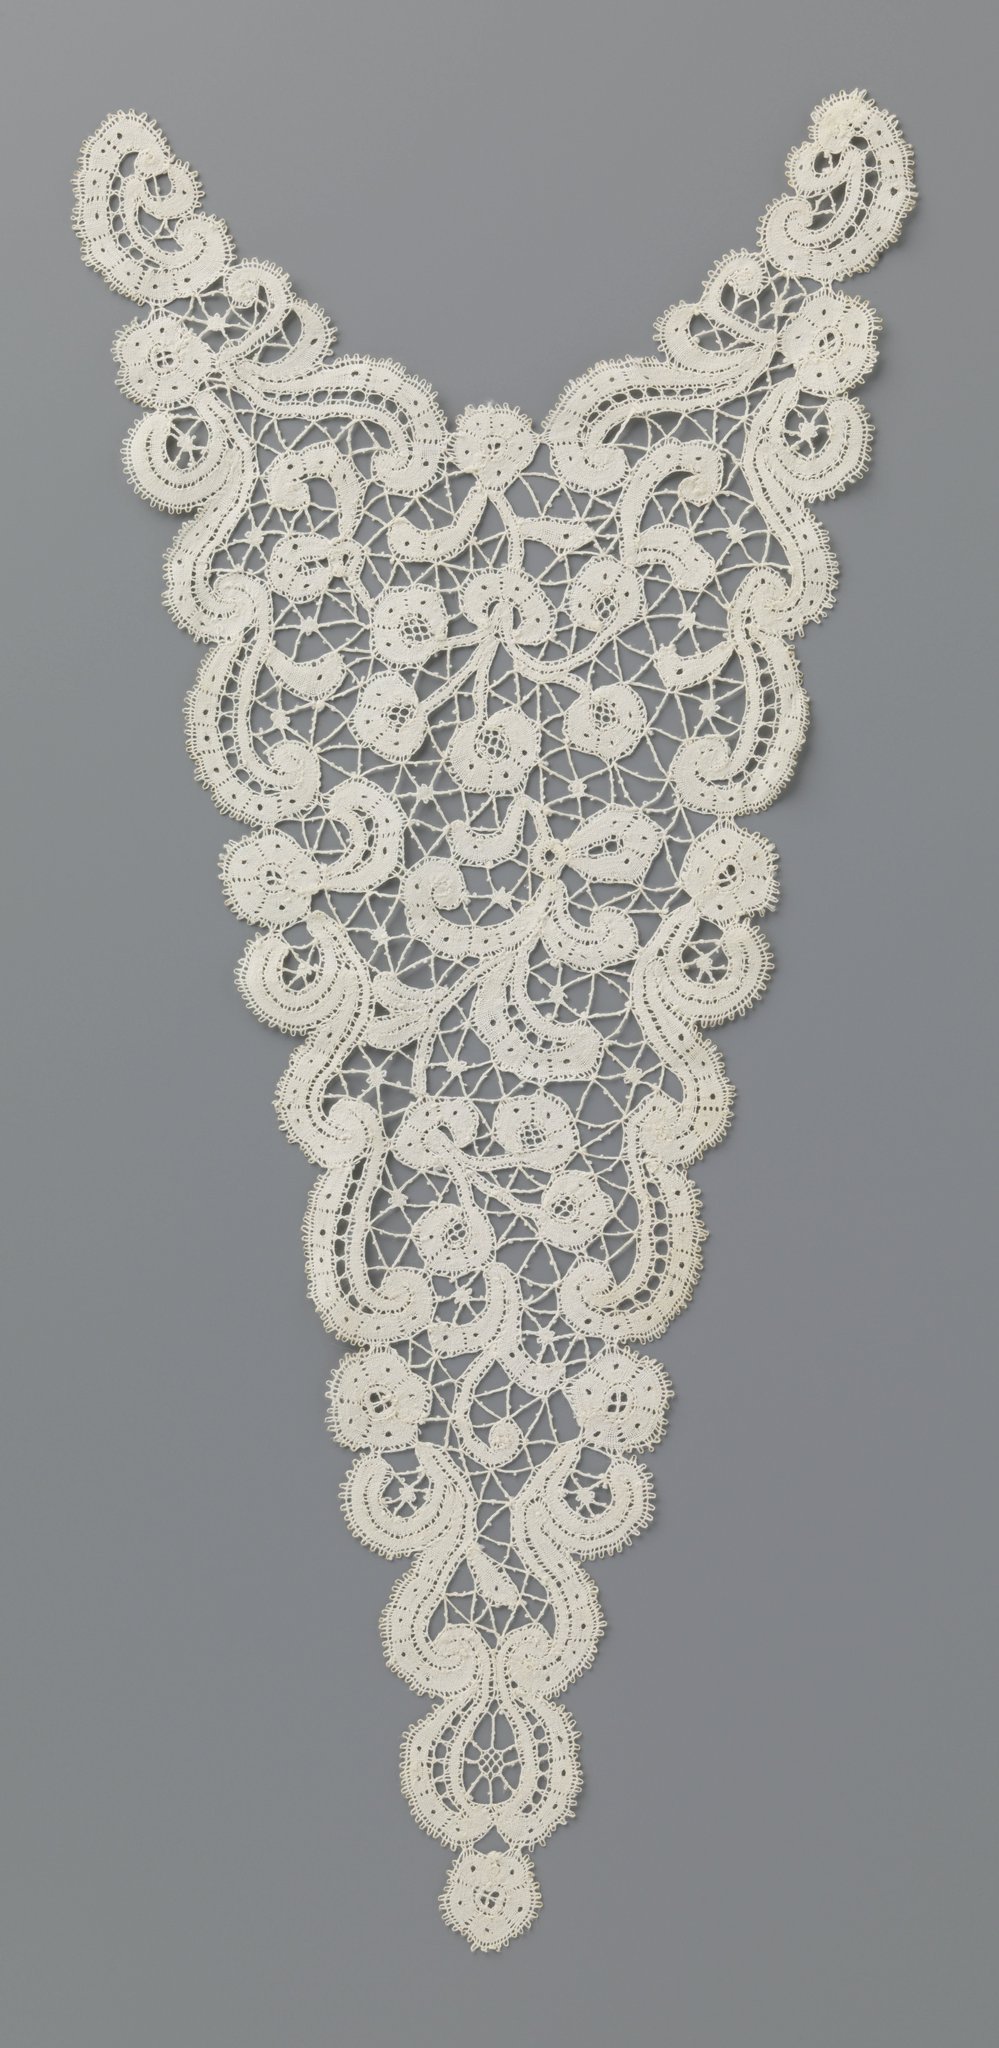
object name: vest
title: Vest van kloskant met hangende tros in symmetrische omlijsting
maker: leon sacré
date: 1907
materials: linen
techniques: lace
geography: brussels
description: Driehoekig vest van naturelkleurige kloskant, Vlaamse guipure. In een symmetrische omlijsting van s-voluten, rozetjes en c-voluten hangt een asymmetrische tros met rondvormige vruchten of bloemen. Vlechtengrond. Afwerking aan alle zijden met ongelijke schulpen, die voortkomen uit het patroon.